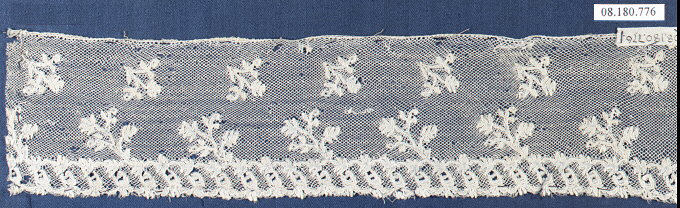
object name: fragment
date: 1701-1800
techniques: lace